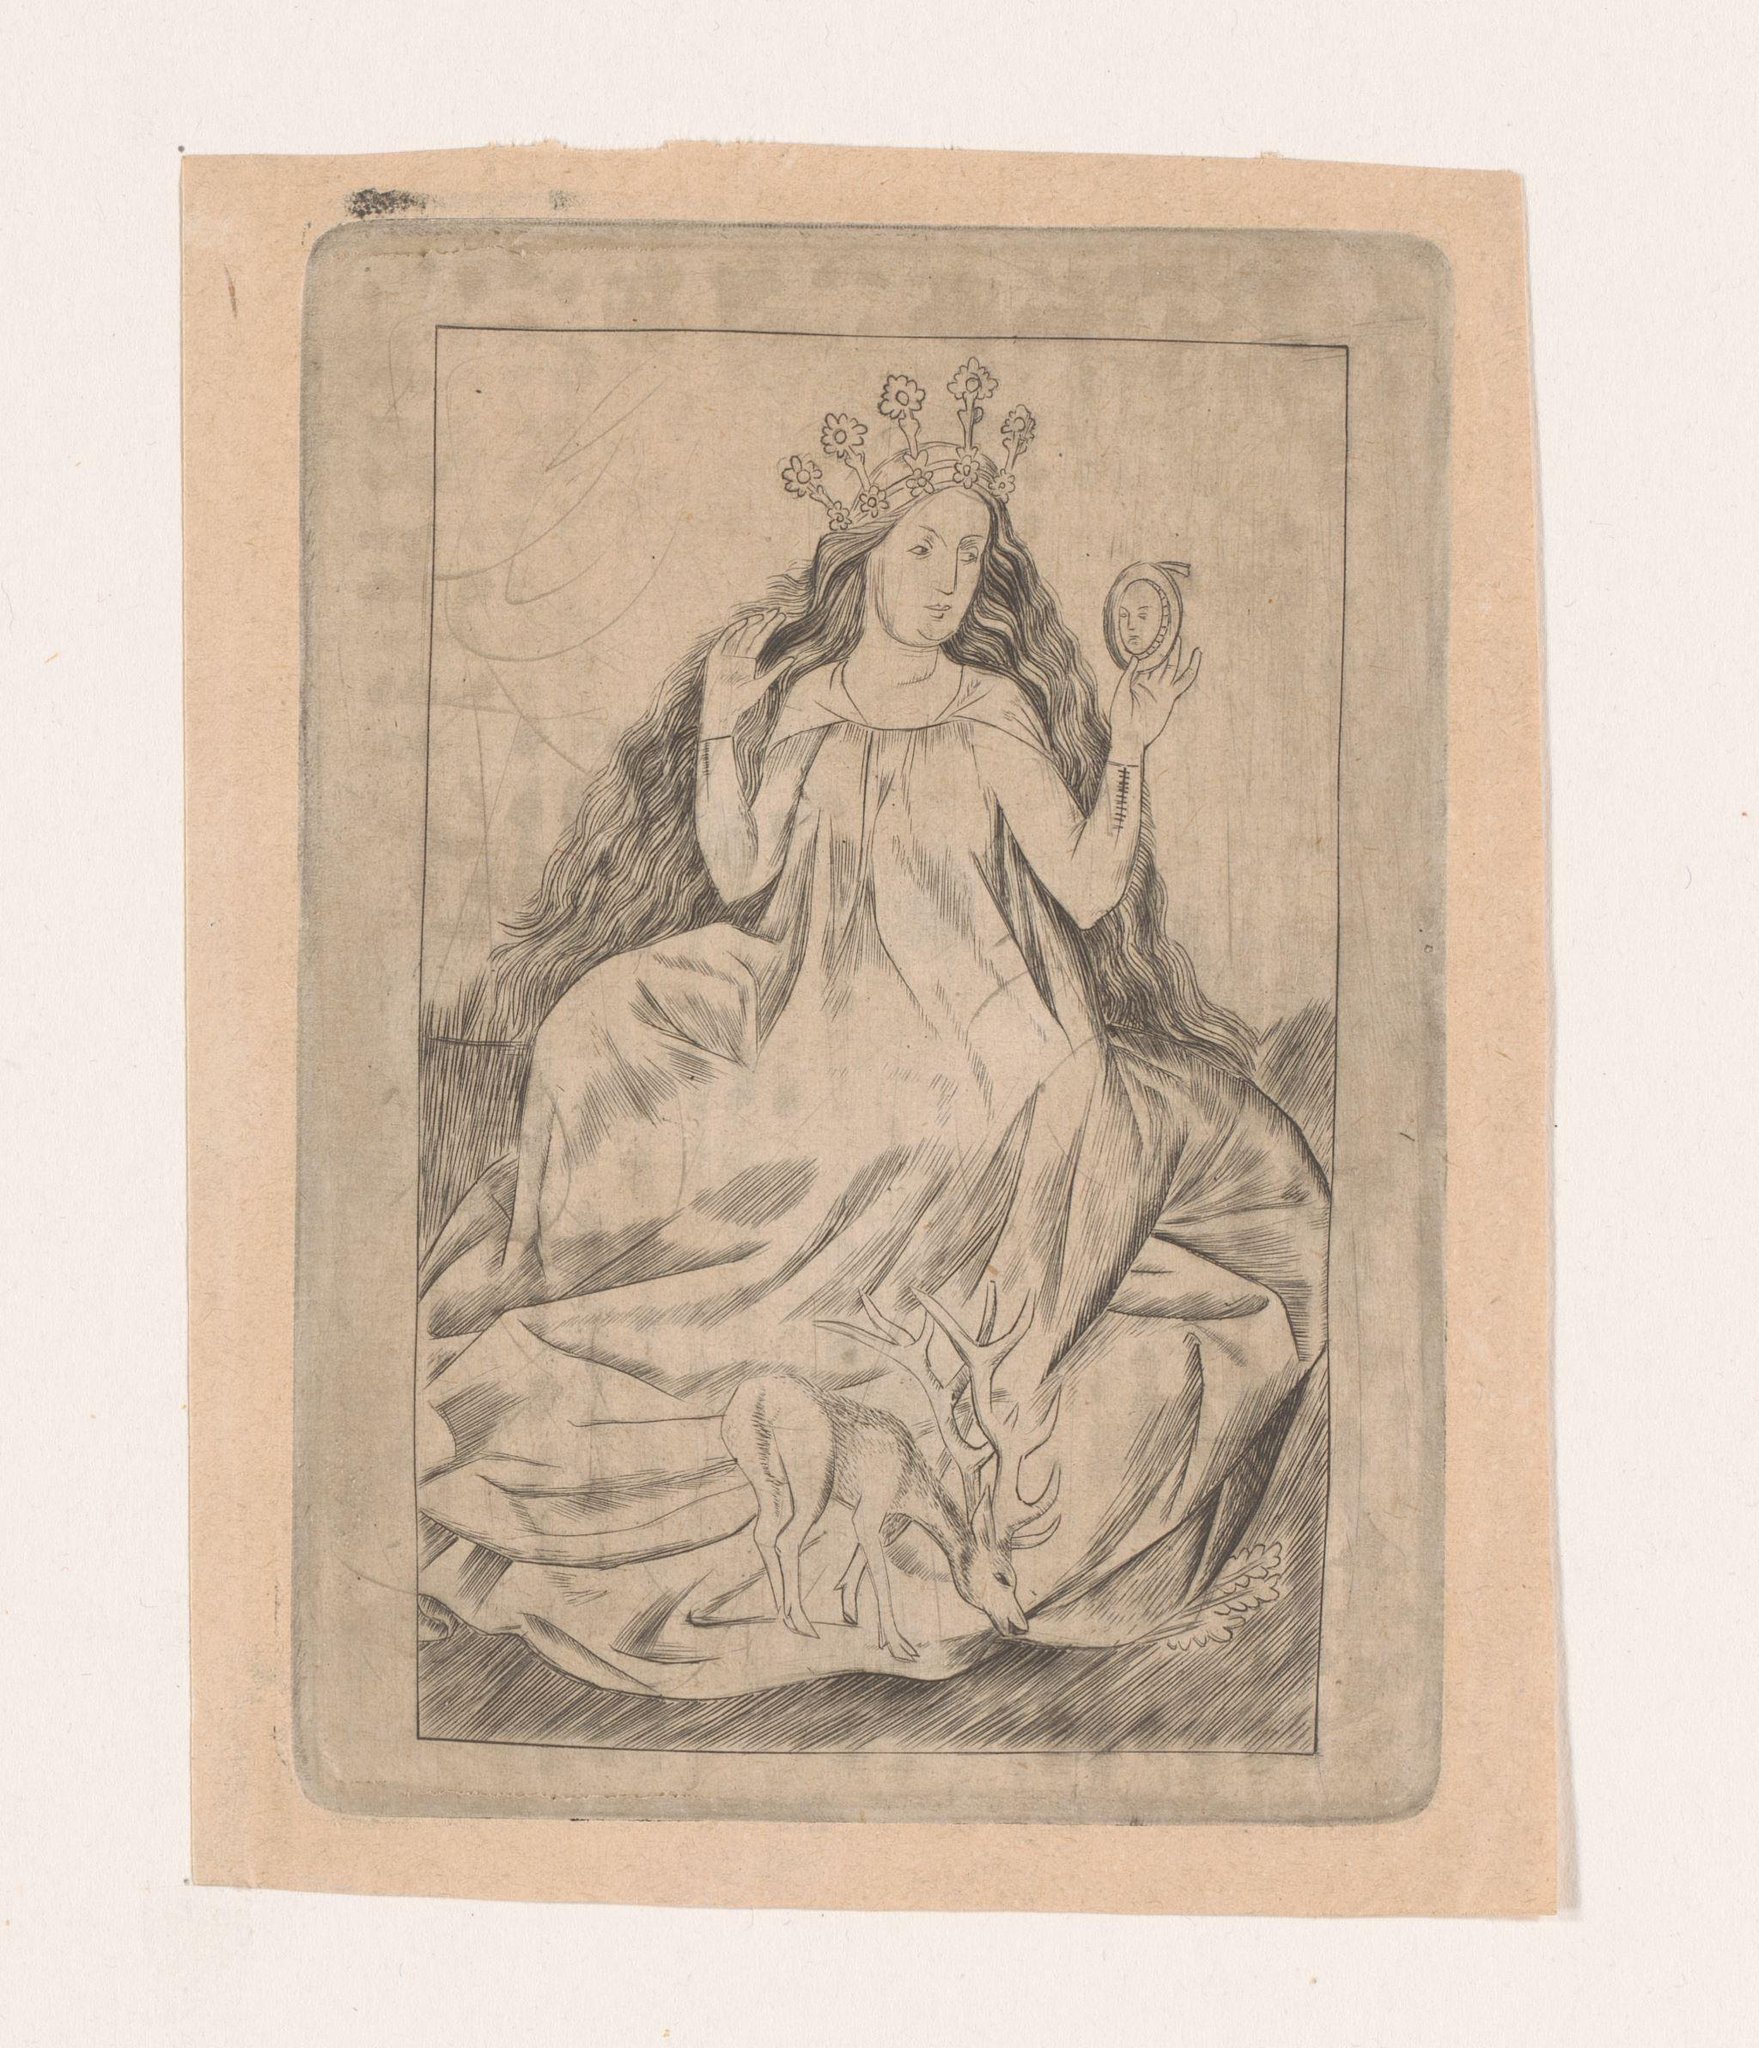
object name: print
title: Koningin van de herten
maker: Anonymous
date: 1848-1947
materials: paper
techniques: drypoint, engraving, intaglio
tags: hoofed animals: stag, queen, playing-cards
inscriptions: collector's mark: Lugt 2228